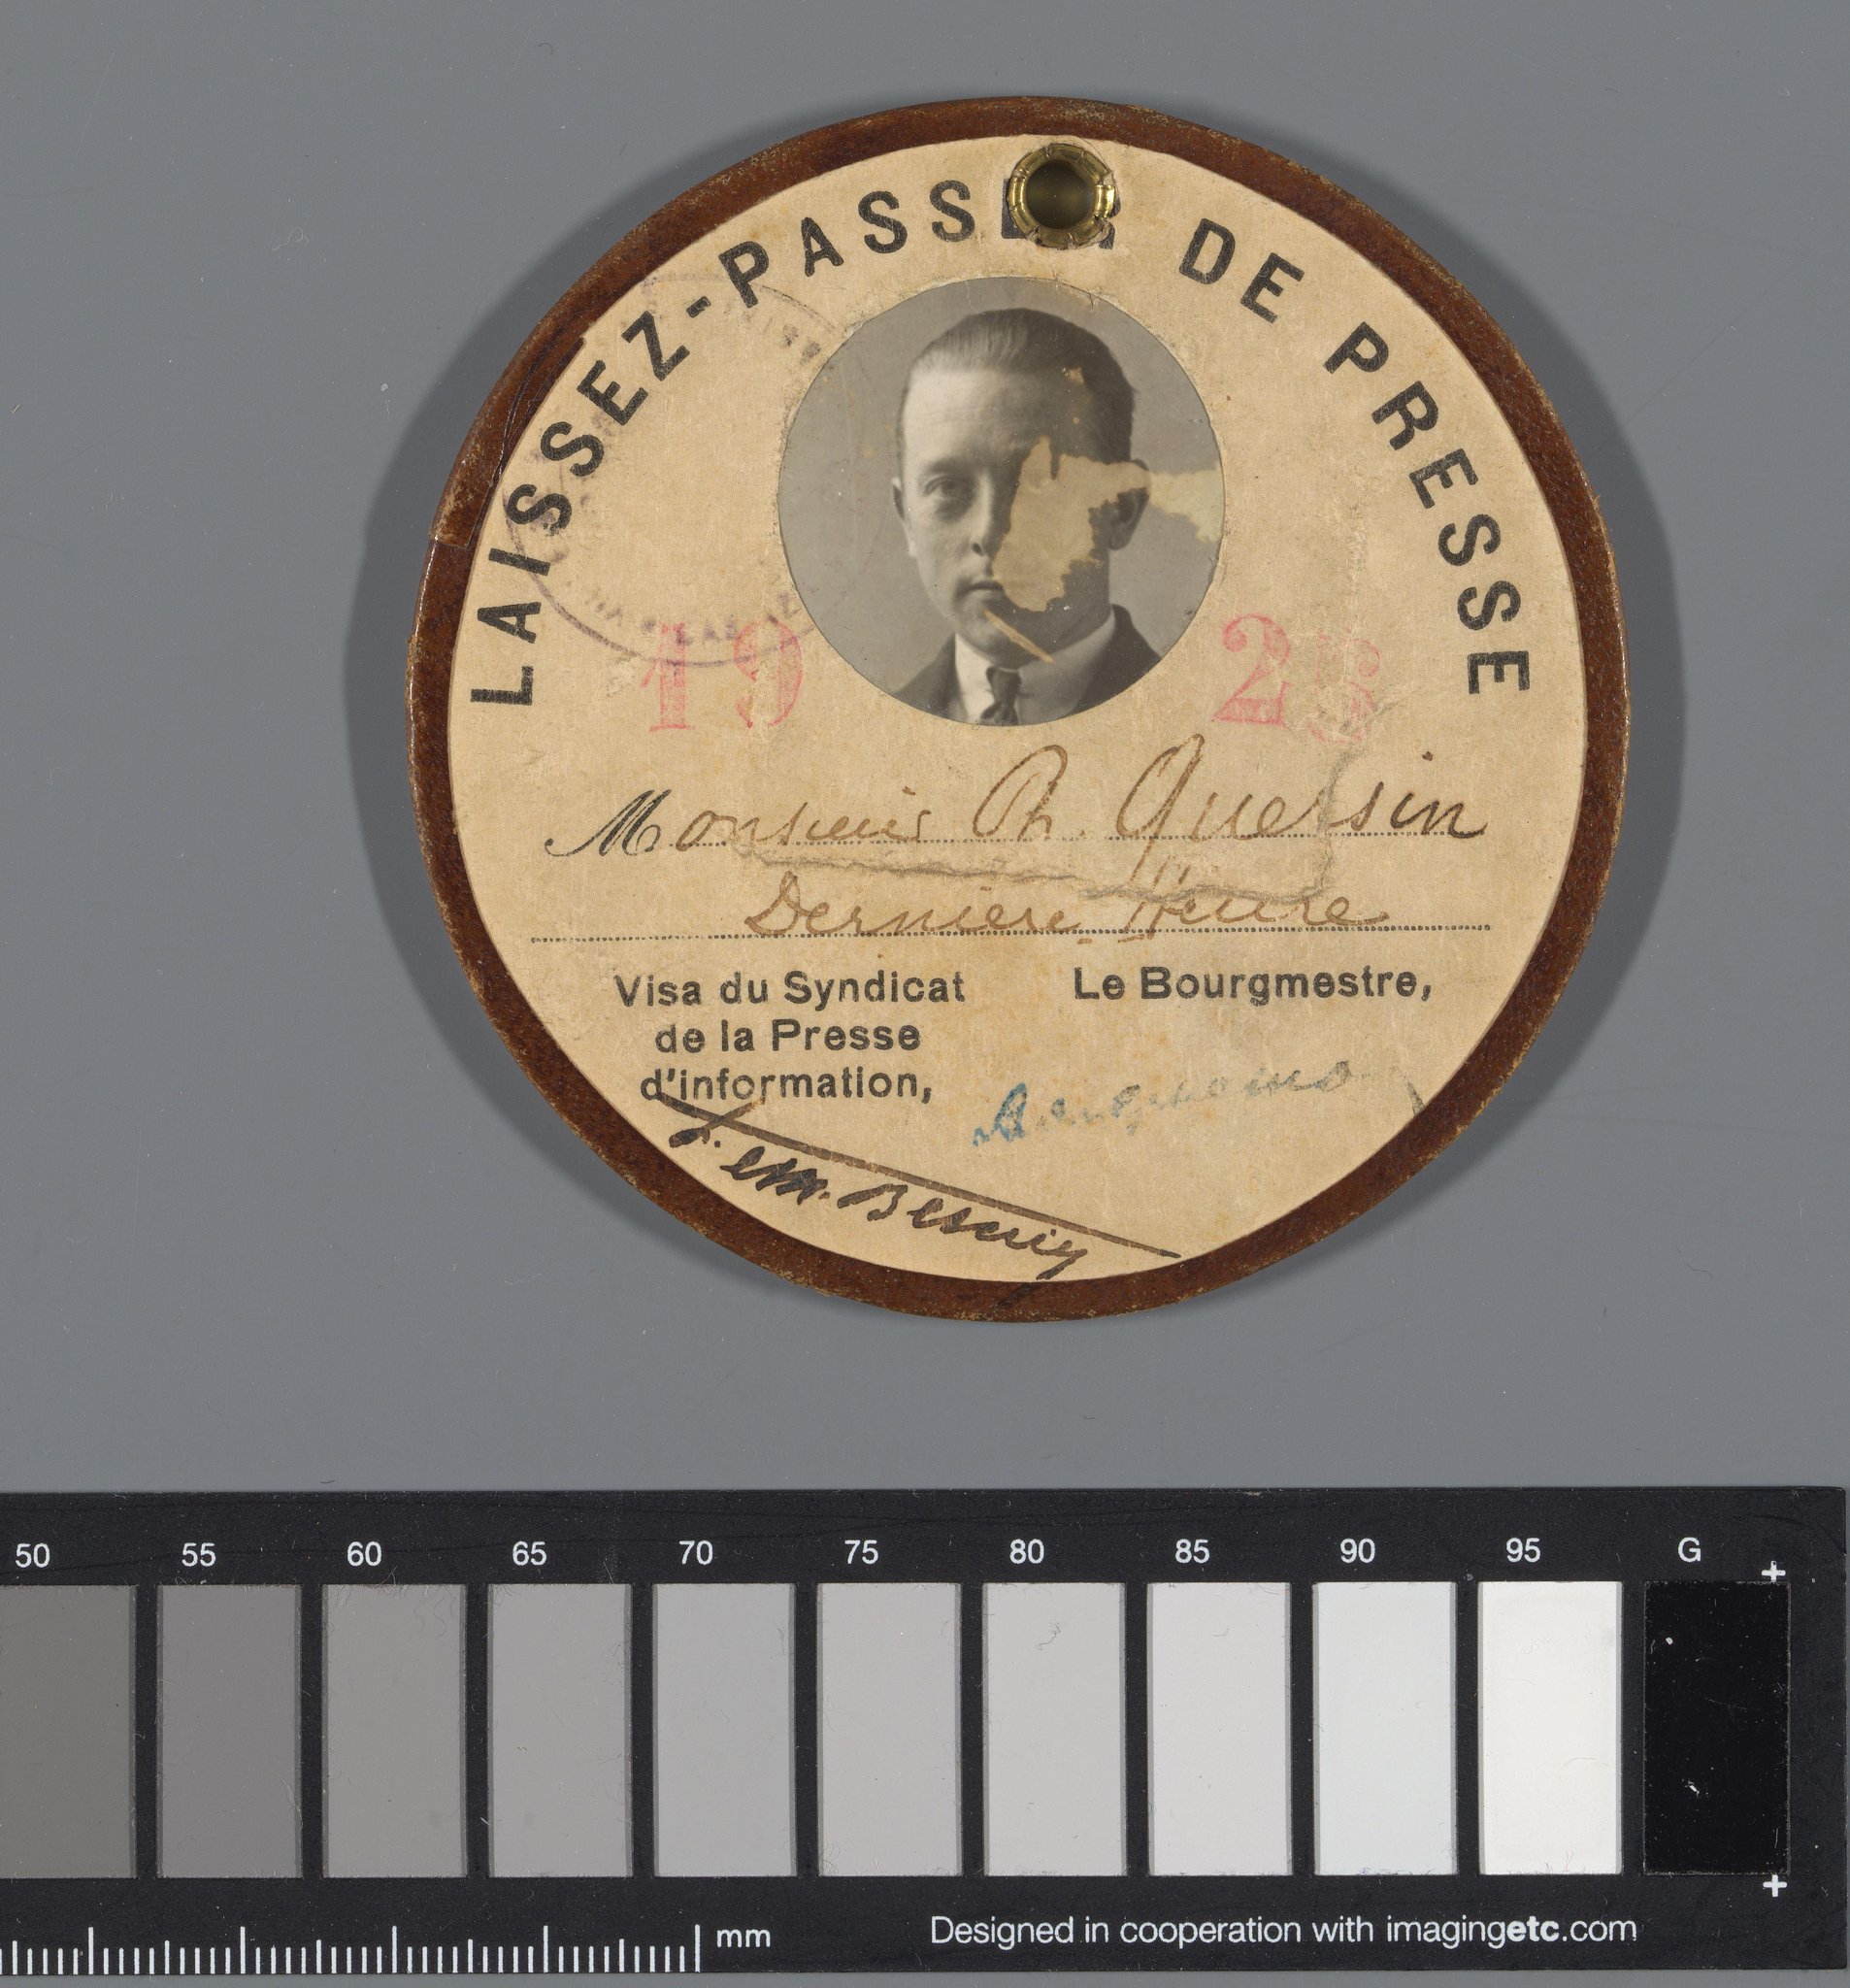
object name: identity card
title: Portret van journalist Ph. Quersin van de krant 'La Dernière Heure', op ronde perskaart, 1925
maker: Anonymous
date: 1925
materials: paper, ink, leather, metal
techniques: gelatin silver print, letterpress printing, pen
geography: brussels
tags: journalist, reporter, historical persons, brussels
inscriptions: inscription: ‘Ville de Bruxelles & Agglomération Bruxelloise/ 1925’, inscription: ‘Laissez-Passer de Presse/ 1925/ Monsieur Ph. Quersin/ Dernière Heure/ Visa du Syndicat Le Bourgmestre,/ de la Presse/ d'Information,/ [...]’